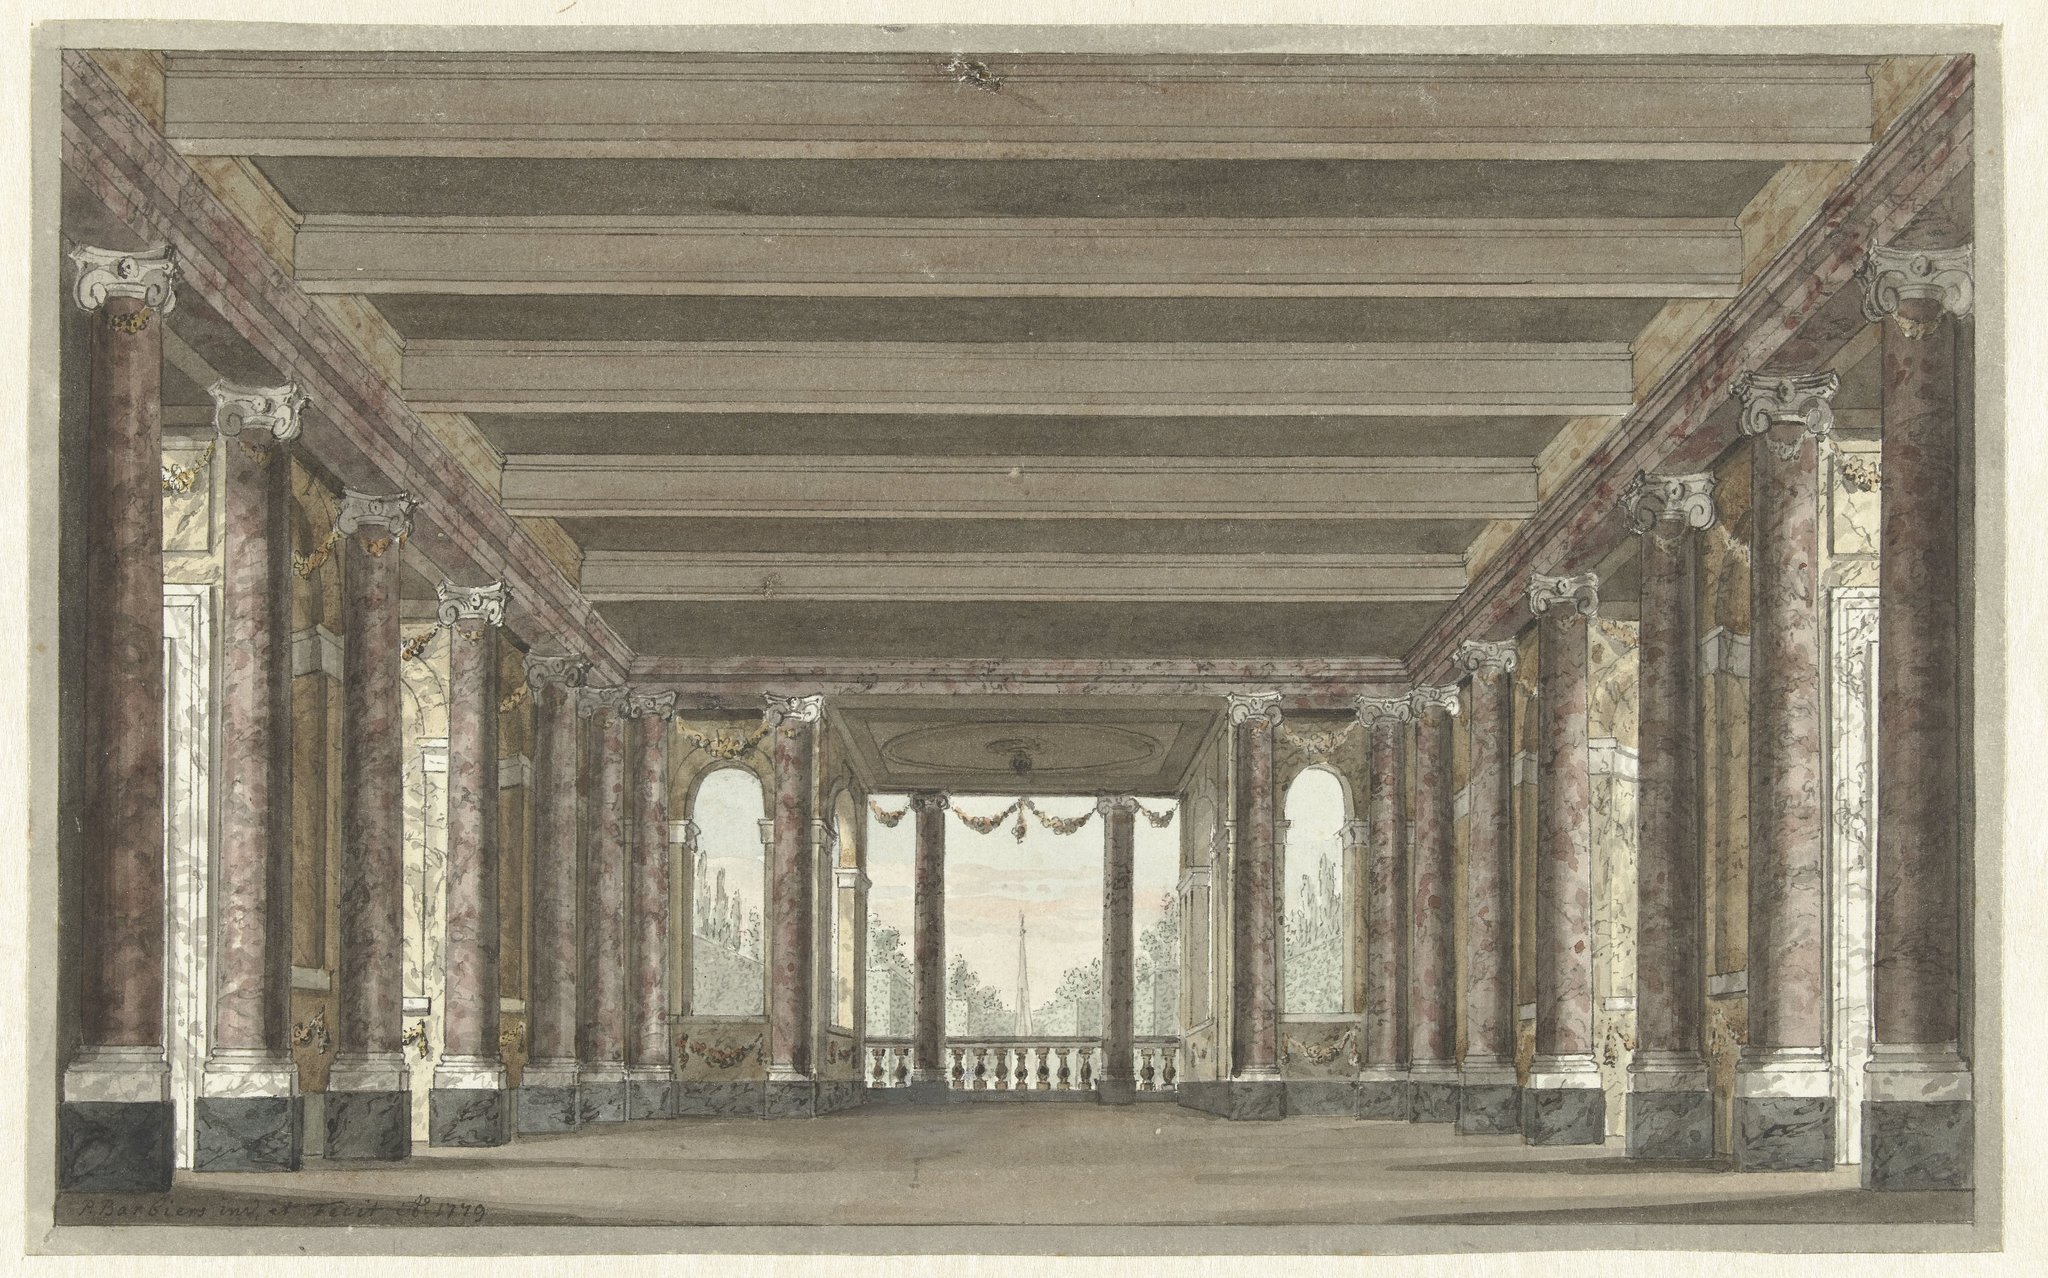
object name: drawing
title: Ontwerp voor een toneeldecor van een zuilengalerij met loggia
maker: pieter barbiers (i)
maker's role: print maker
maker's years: 1717-1780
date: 1779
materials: graphite, ink, paper, watercolor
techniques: brush, pen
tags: stage design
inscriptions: date: ‘1779’